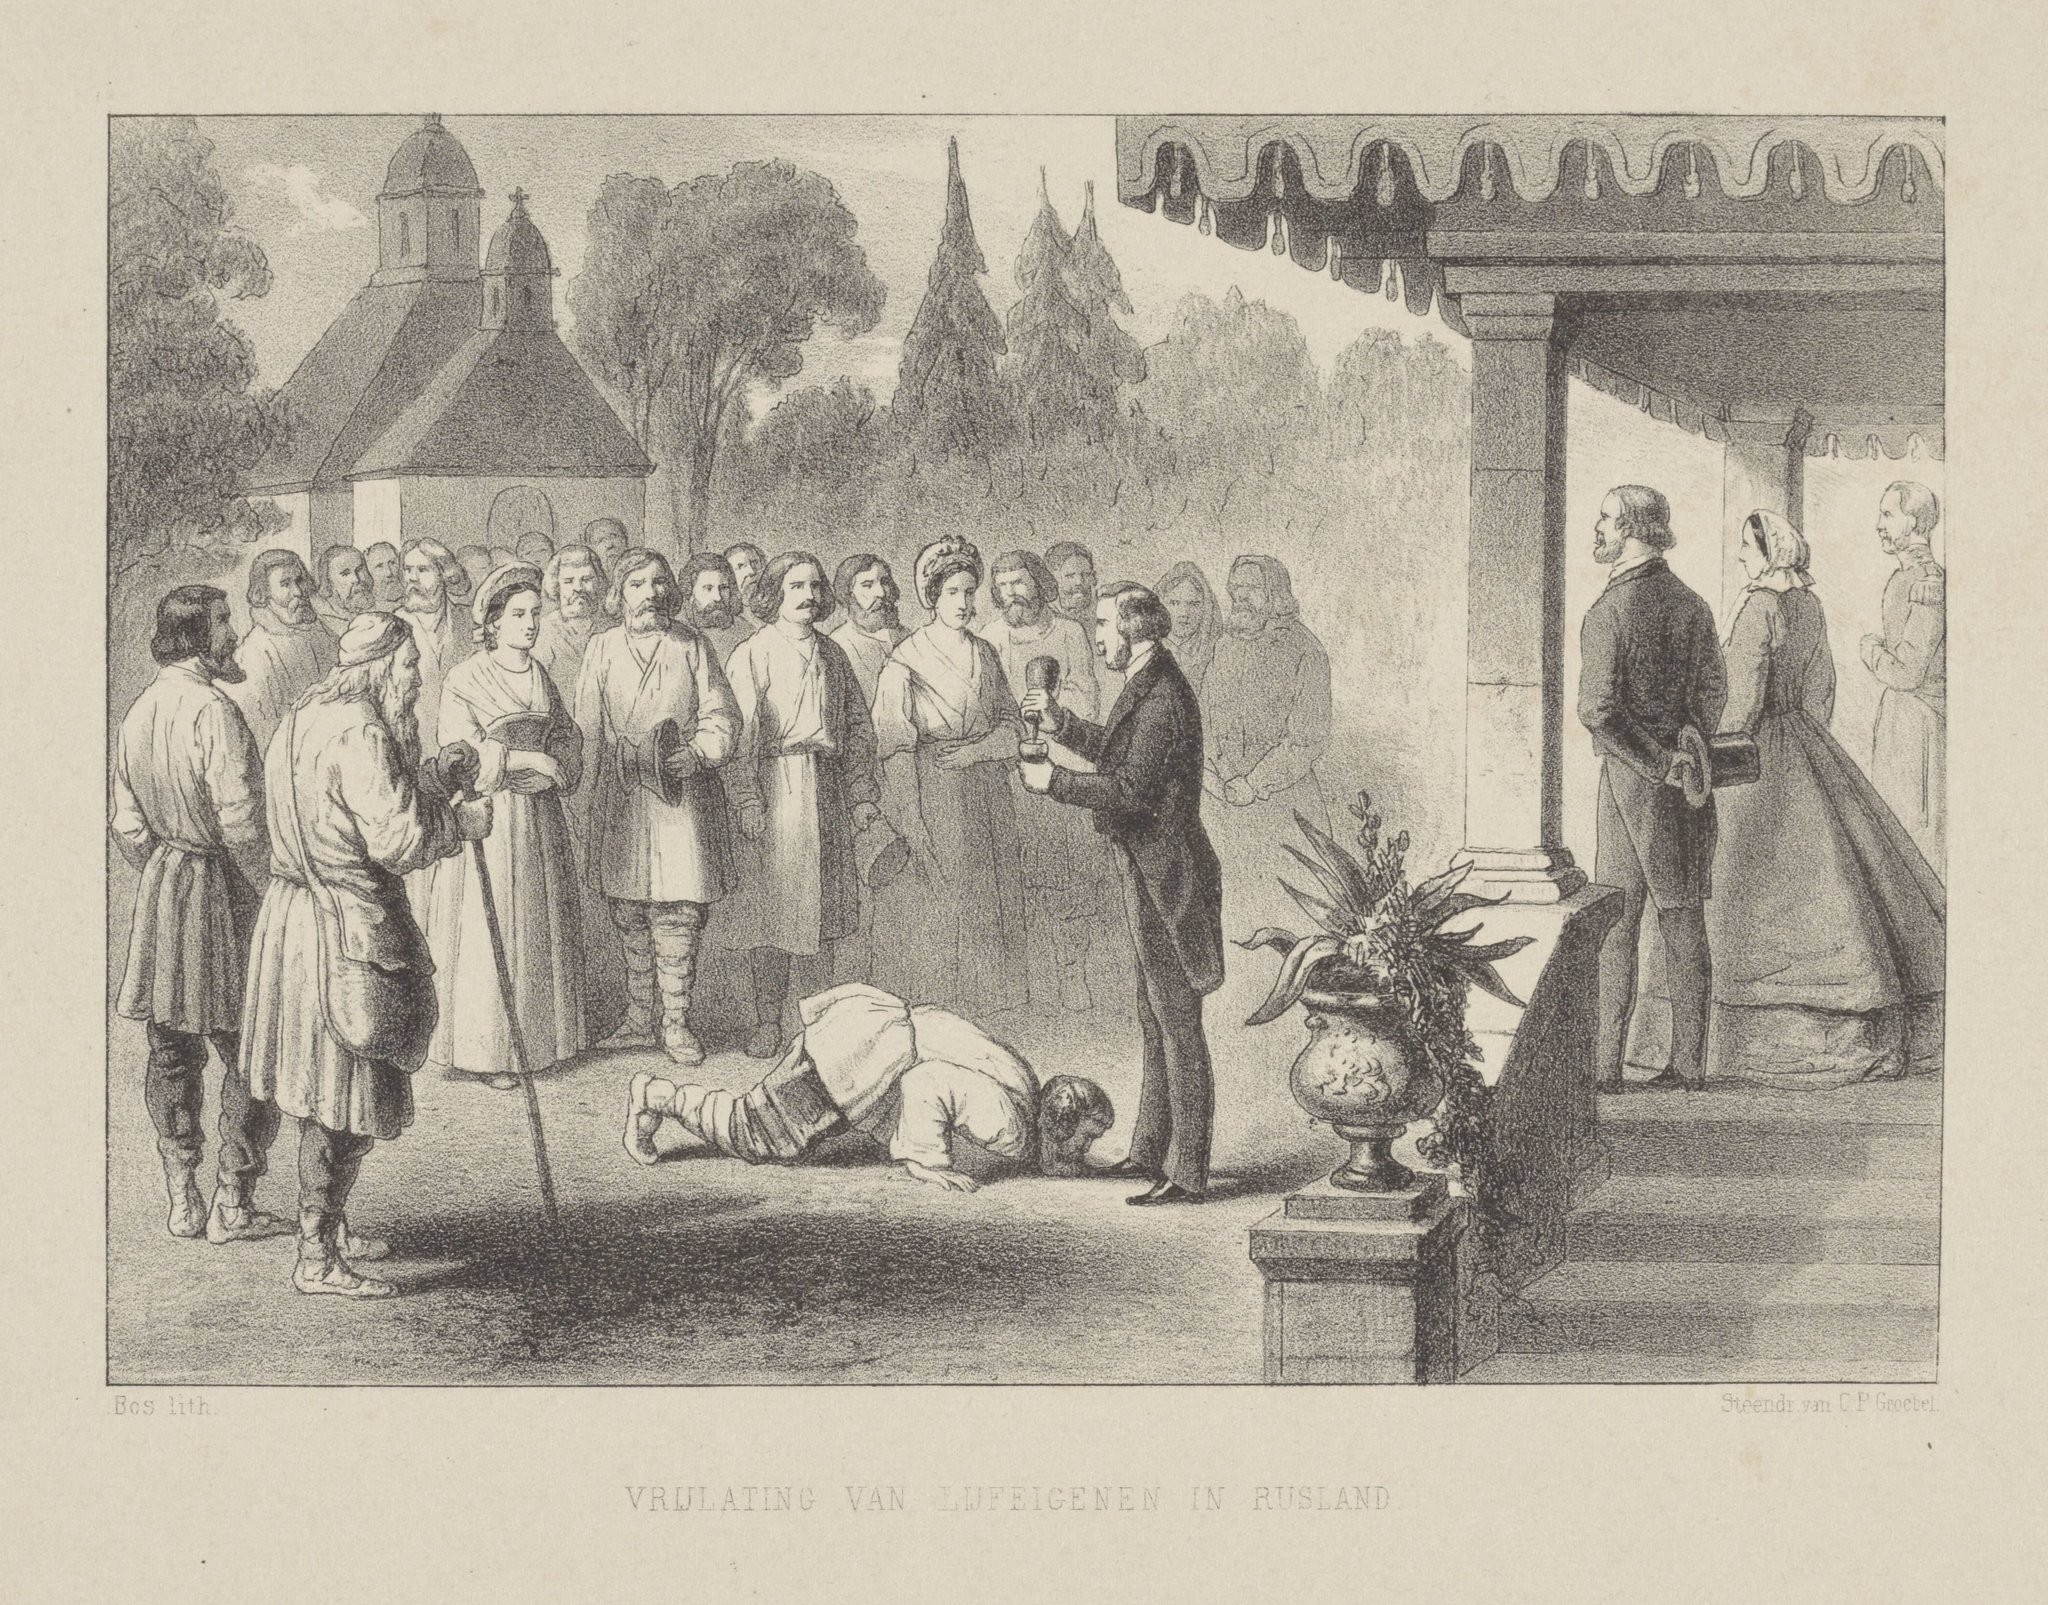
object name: print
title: Vrijlating van lijfeigenen in Rusland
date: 1861-1862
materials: paper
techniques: lithograph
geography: arnhem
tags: pouring, slavery; serfs and enslaved persons, freedom ~ slavery, russia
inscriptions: collector's mark: Lugt 2228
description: Een groep boeren heeft zich verzameld voor de veranda van een huis. Daarop staan een heer, een dame en een man in een militair kostuum. Voor de veranda staat een man in pak. Hij schenkt een glas vol. Voor hem op de grond zit een boer voorovergebogen en kust zijn voeten.